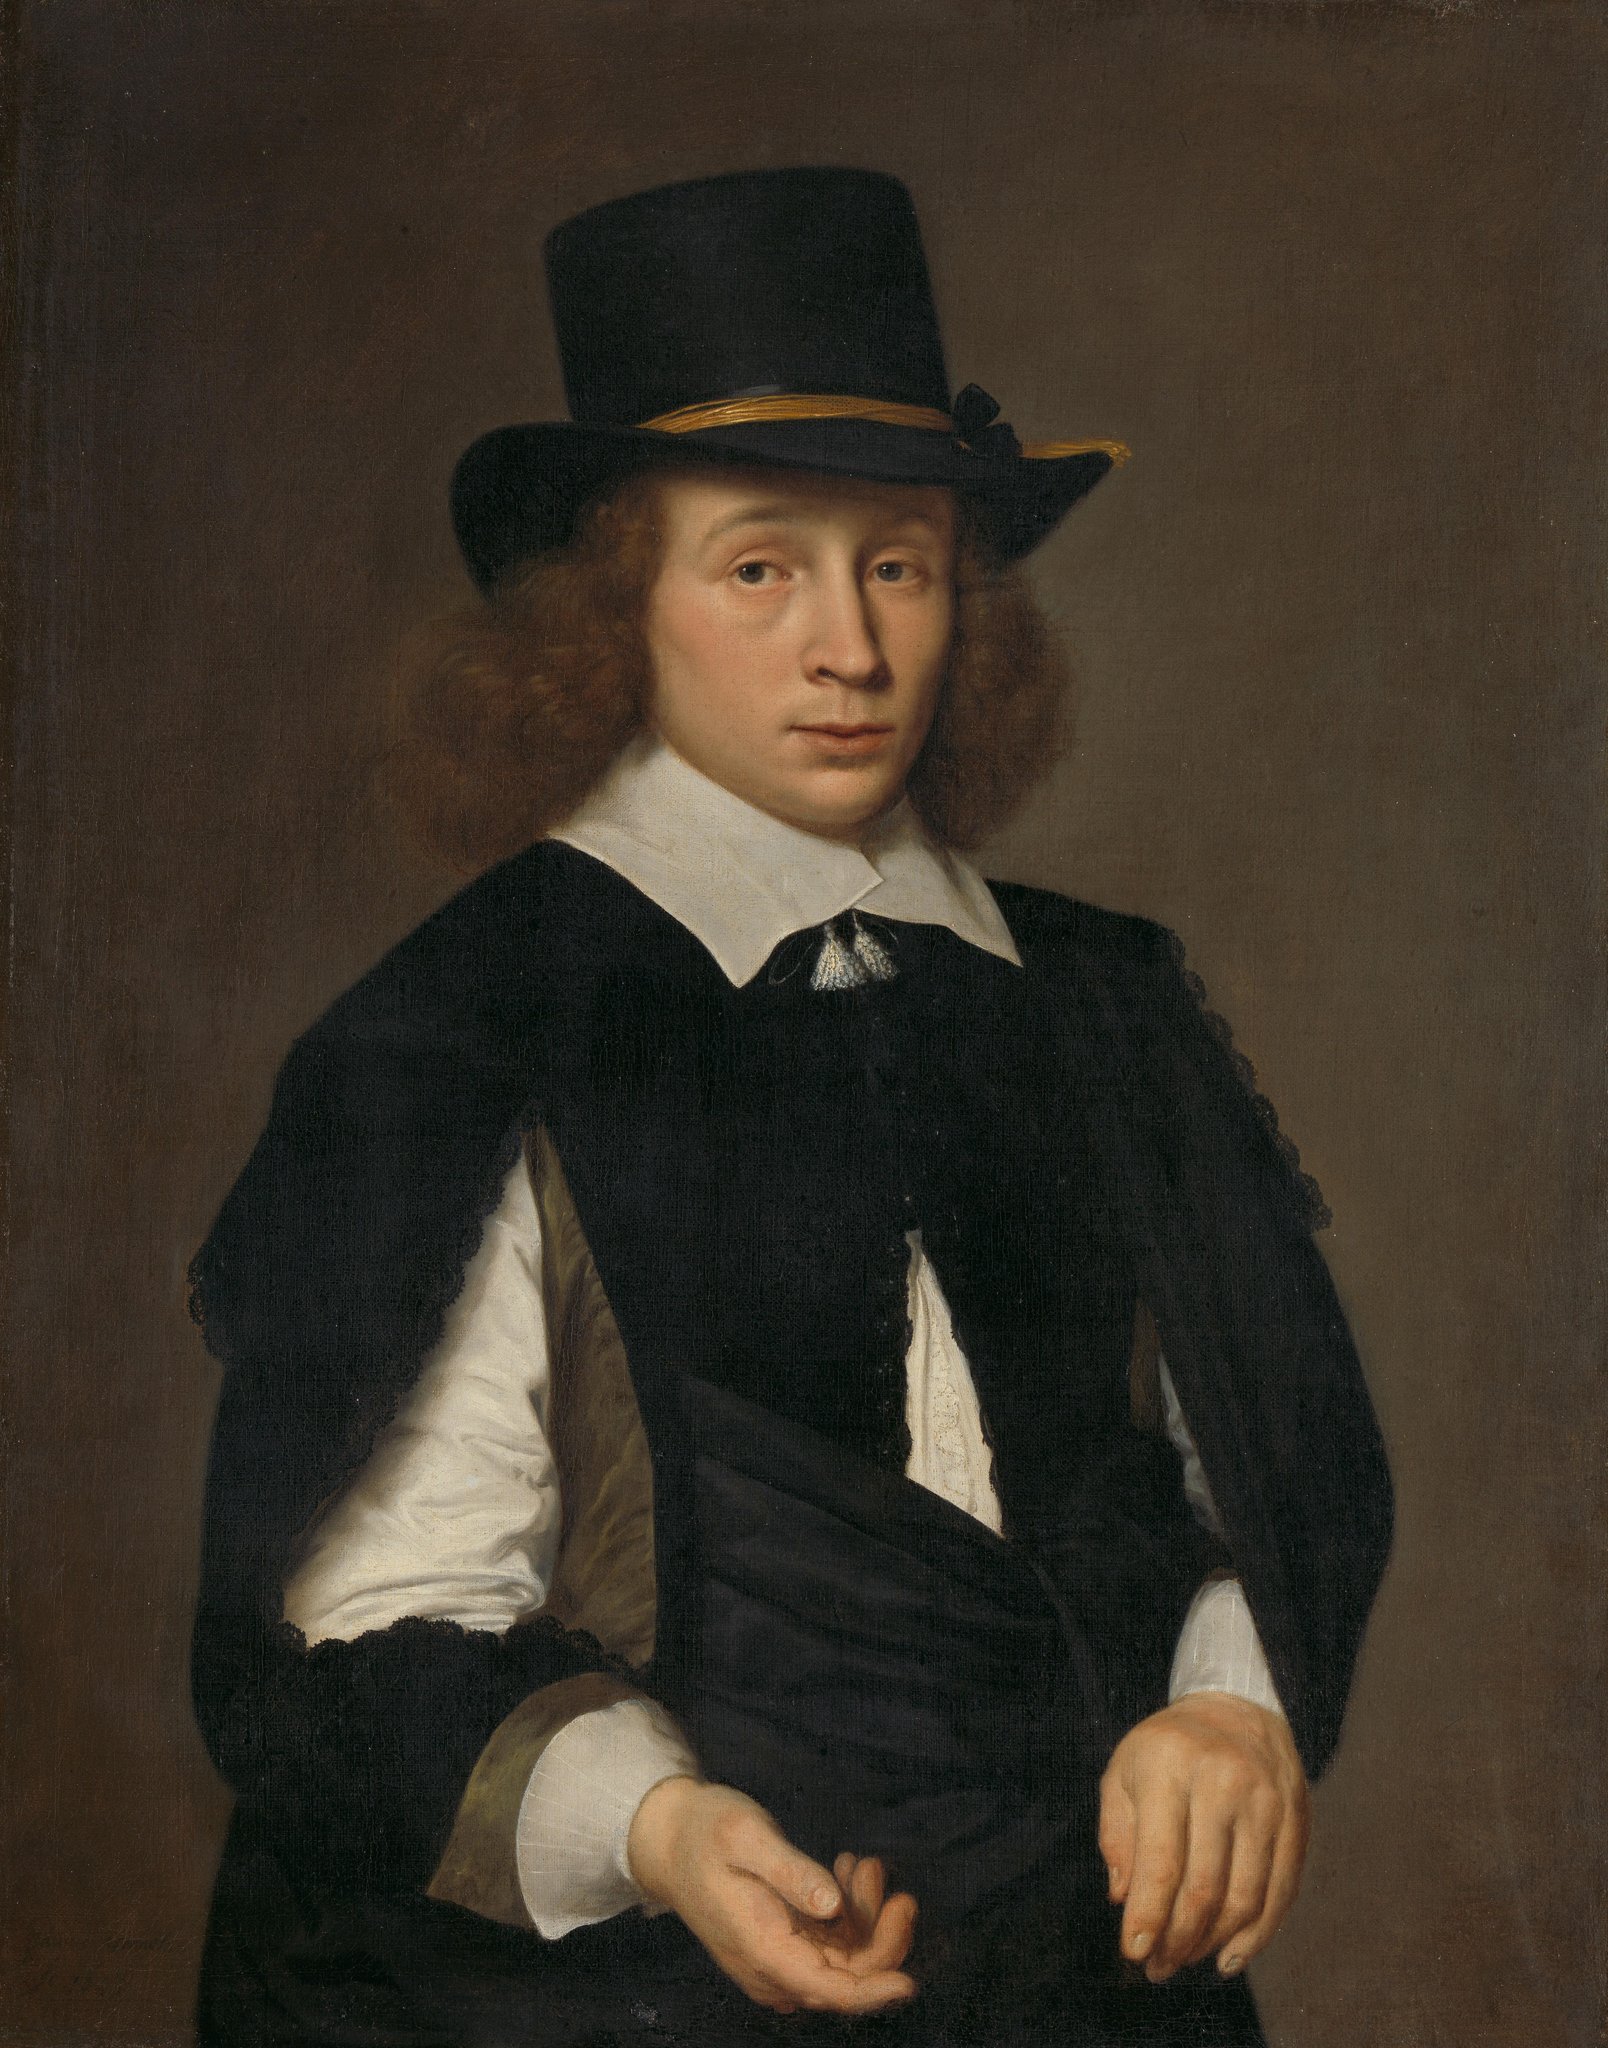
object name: painting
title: Portrait of Dirck Hendrick Meulenaer (1620-in or after 1649 ?)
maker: paulus hennekyn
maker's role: painter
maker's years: 1612-1672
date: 1645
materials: canvas, oil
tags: historical persons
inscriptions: signature and date, lower left: ‘Paulus Hennekyn / fe 16[.]5’, inscription, on the reverse: ‘Dirck Hendrik Meulenaer / zoon van Hendrik Meulenaer / en / Anneg Harms.’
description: Portret van Dirck Hendrick Meulenaer. Staand, ten halven lijve, op het hoofd een hoge zwart hoed.